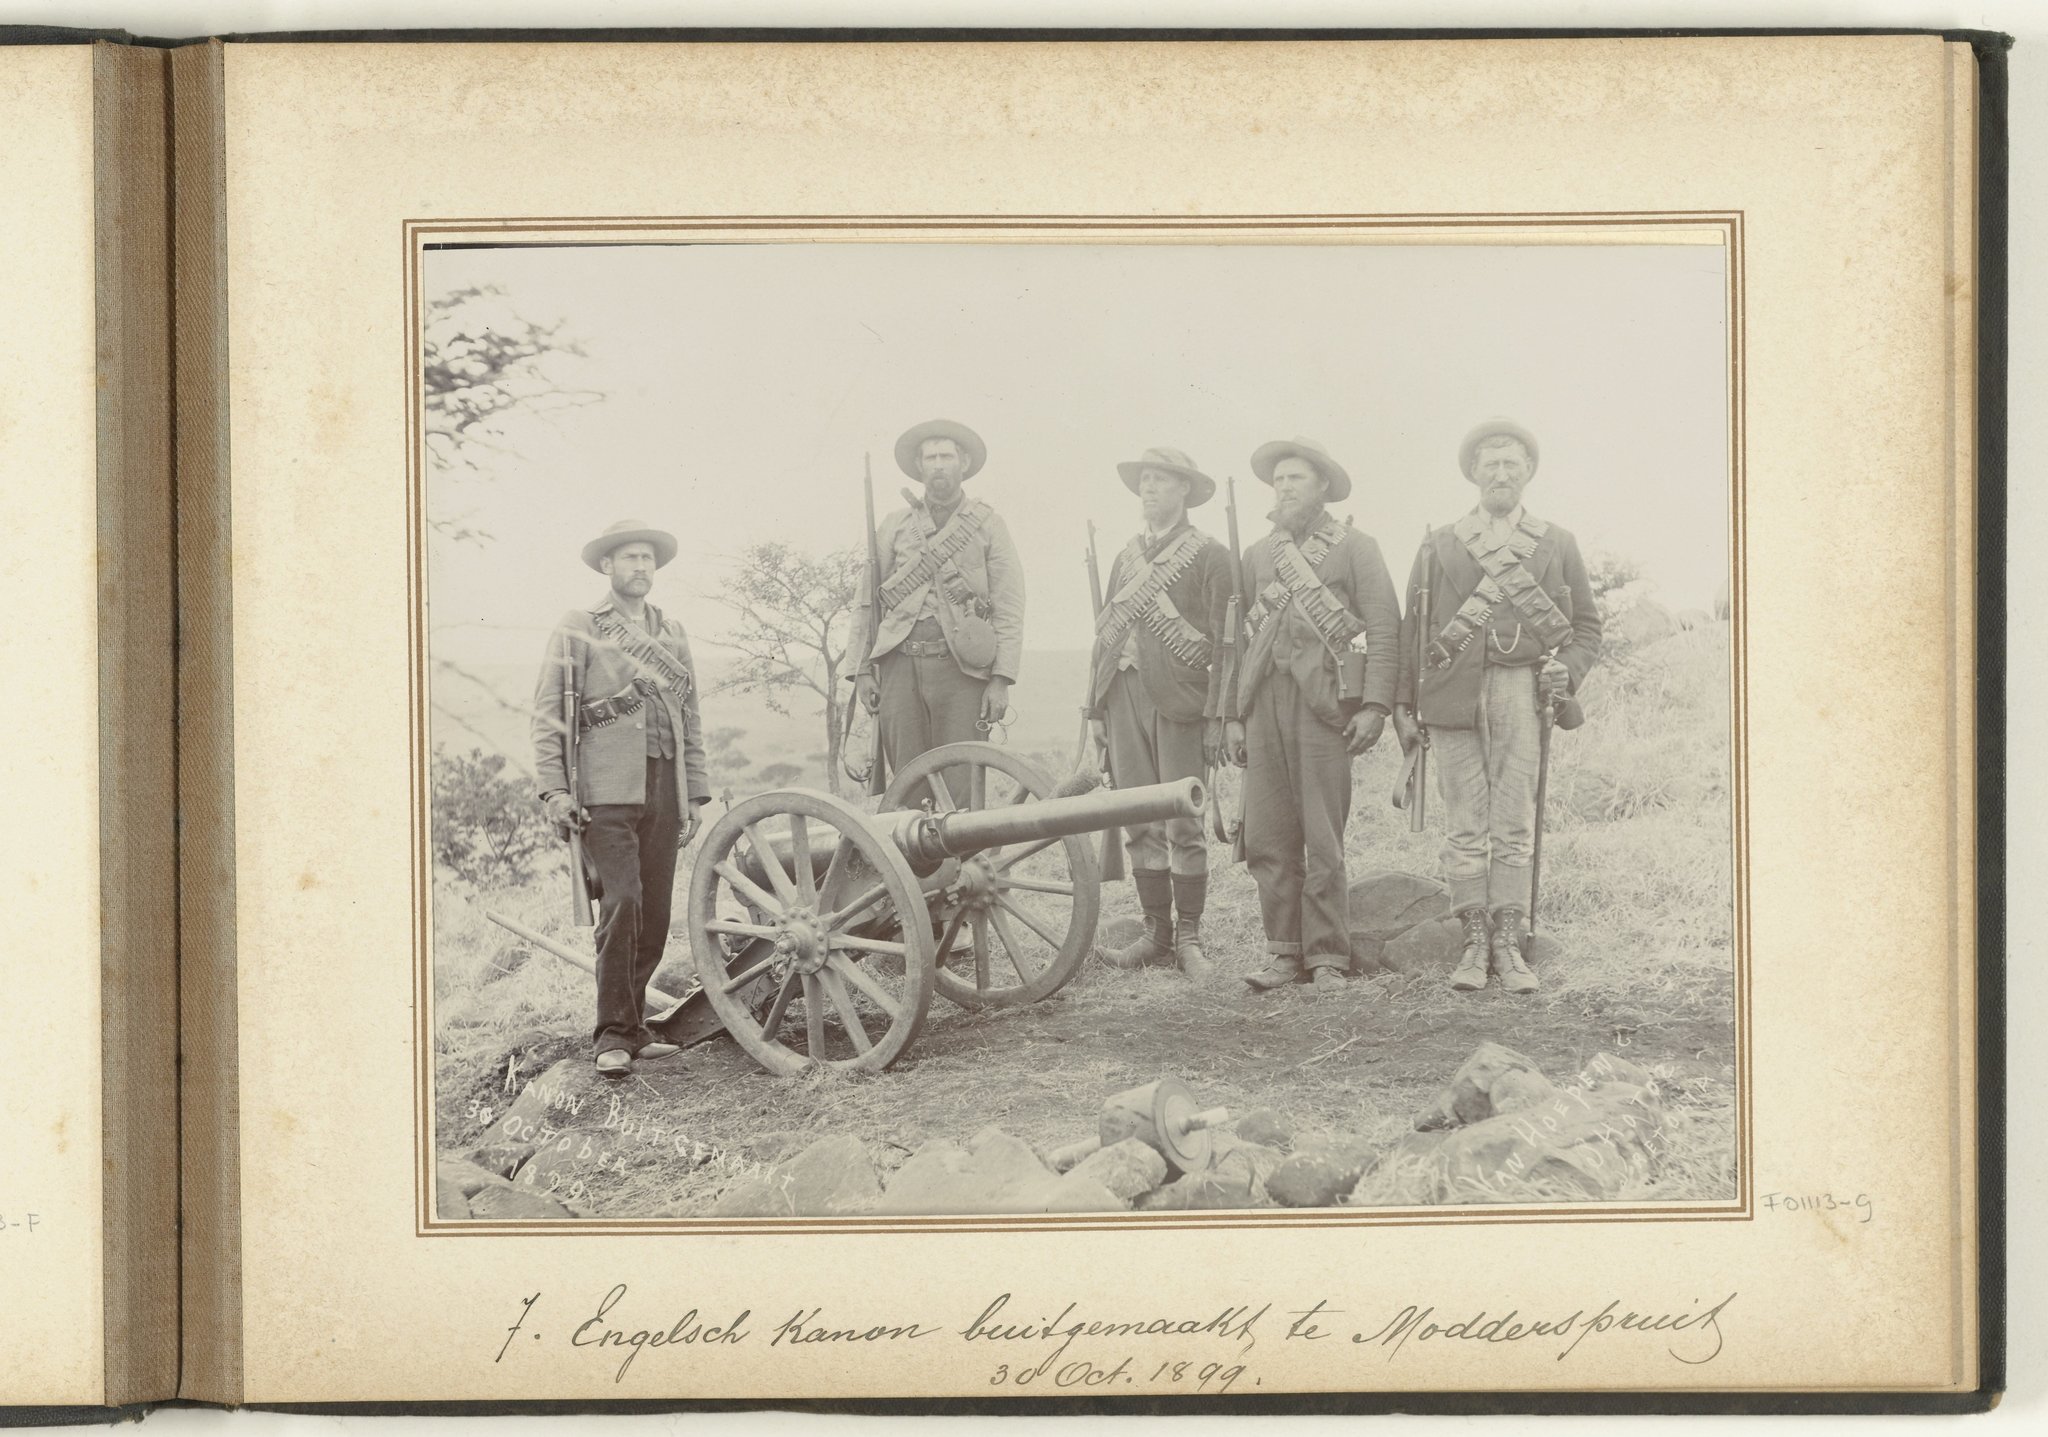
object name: album leaf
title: Kanon Buitgemaakt 30 october 1899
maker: jan van hoepen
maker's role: fotograaf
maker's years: 1856-1922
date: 1899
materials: cardboard, paper, photographic support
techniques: gelatin silver print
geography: south africa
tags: firearms: cannon (+ land forces)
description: Onderdeel van Fotoalbum met opnames van de Tweede Boerenoorlog (1899-1902).